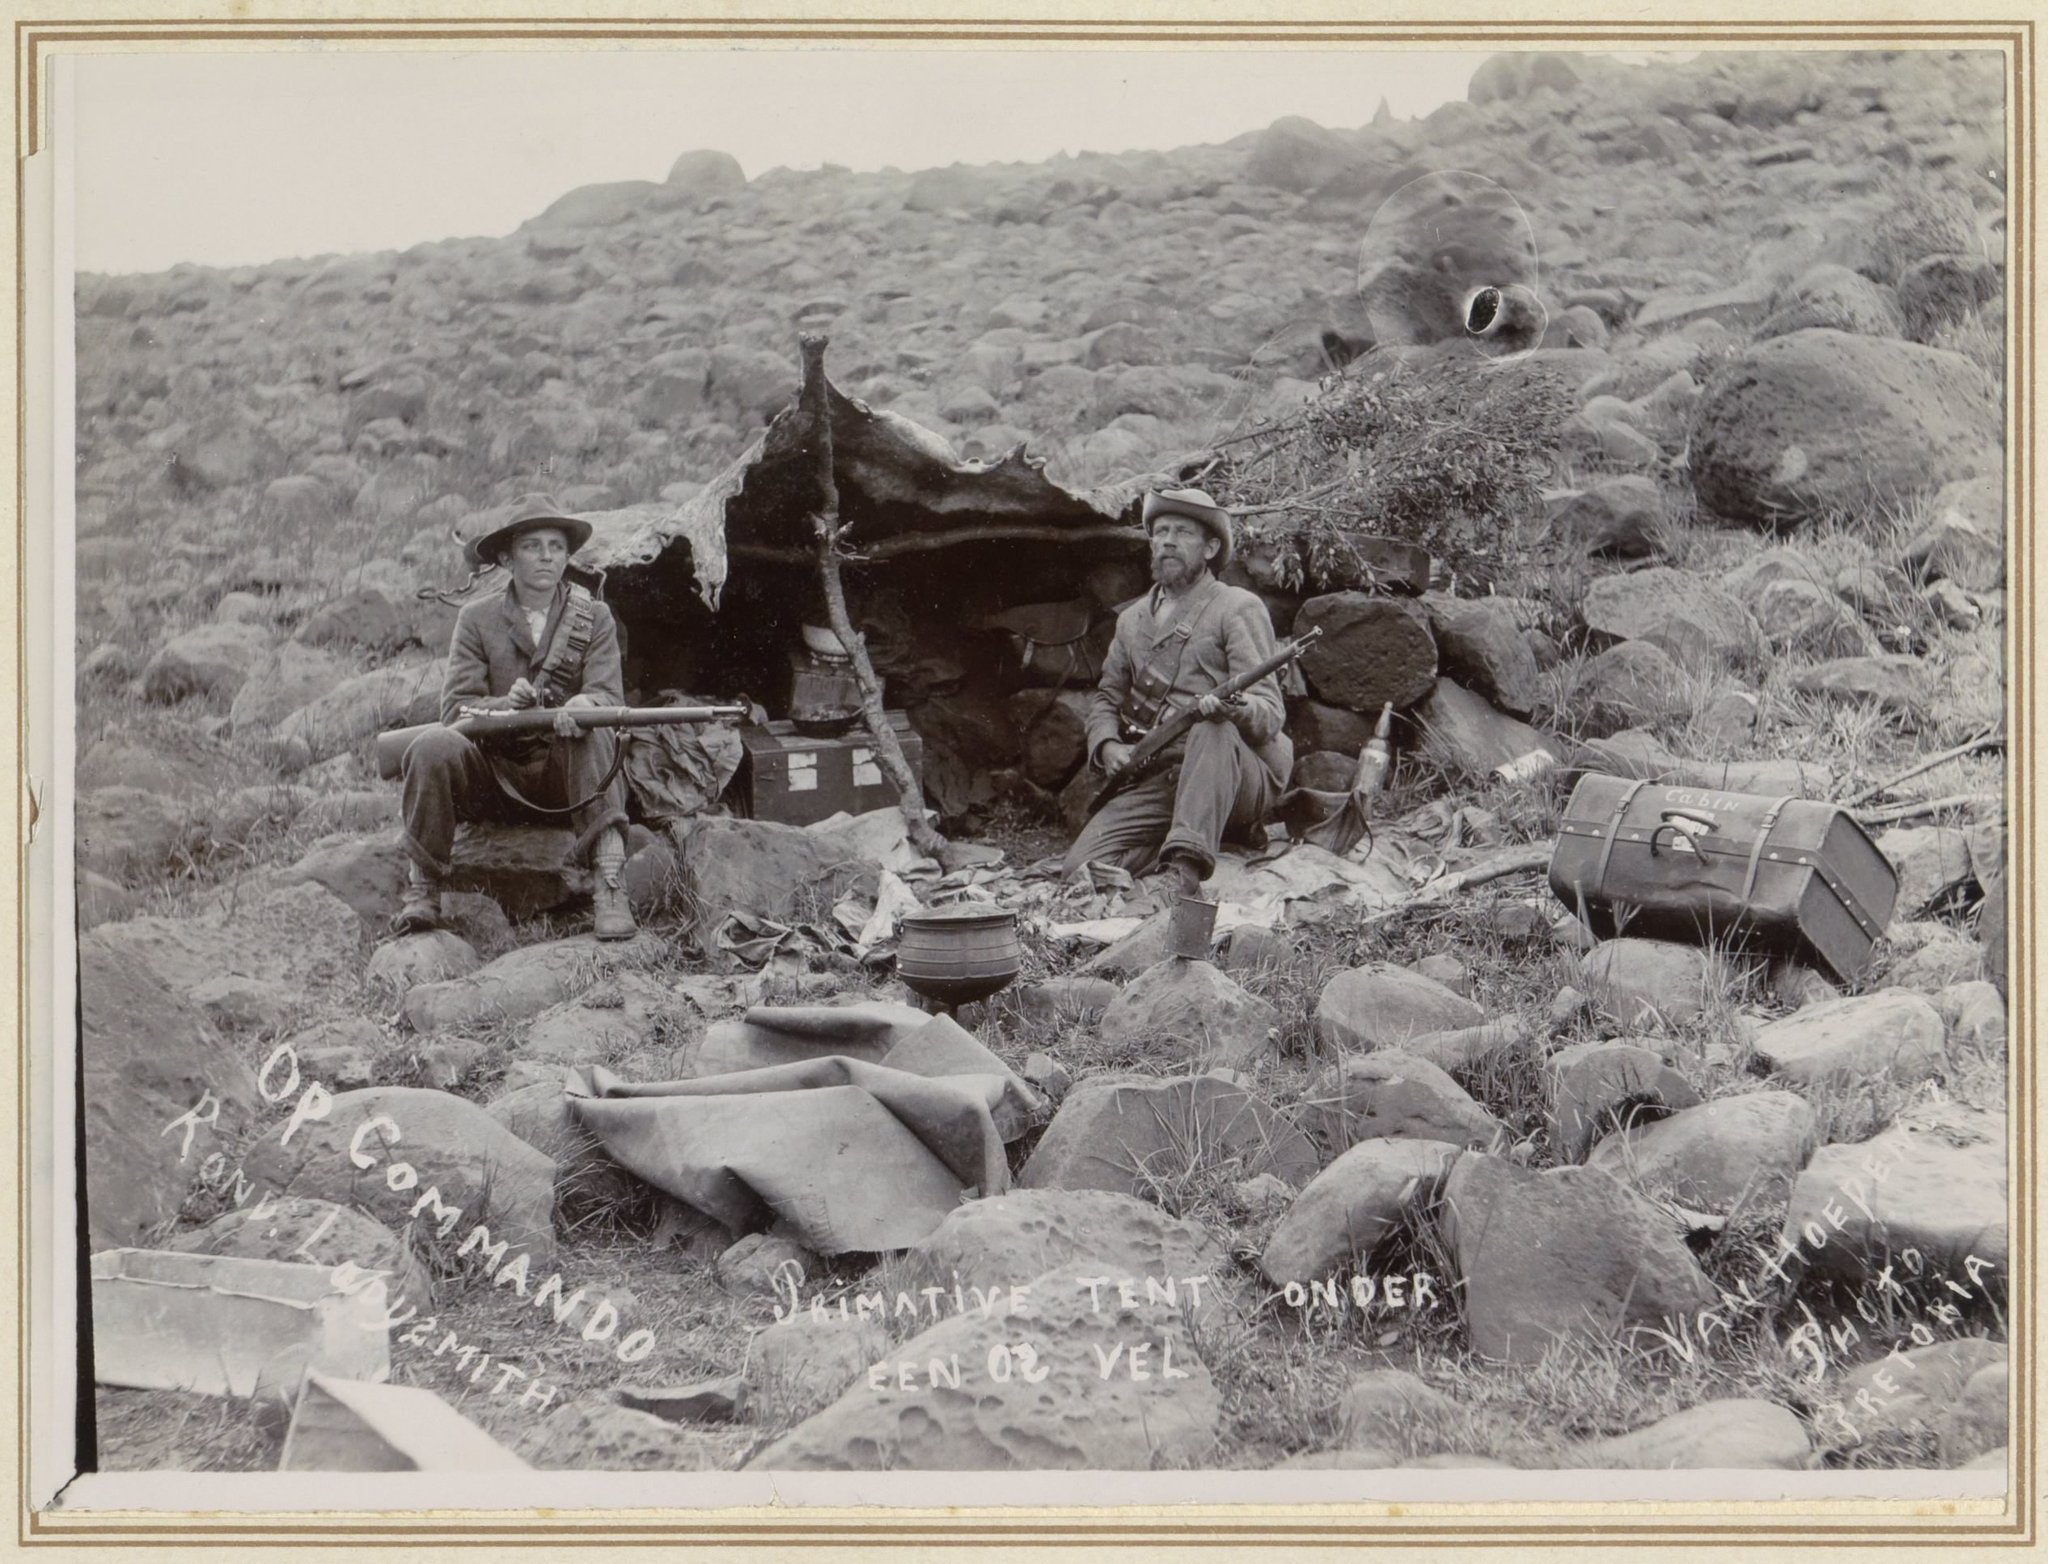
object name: album leaf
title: Op commando rond Ladysmith Primative tent onder een os vel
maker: jan van hoepen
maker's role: fotograaf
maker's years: 1856-1922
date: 1899-1900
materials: cardboard, paper, photographic support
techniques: gelatin silver print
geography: ladysmith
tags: (military) camp with tents, tent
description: Onderdeel van Fotoalbum met opnames van de Tweede Boerenoorlog (1899-1902).